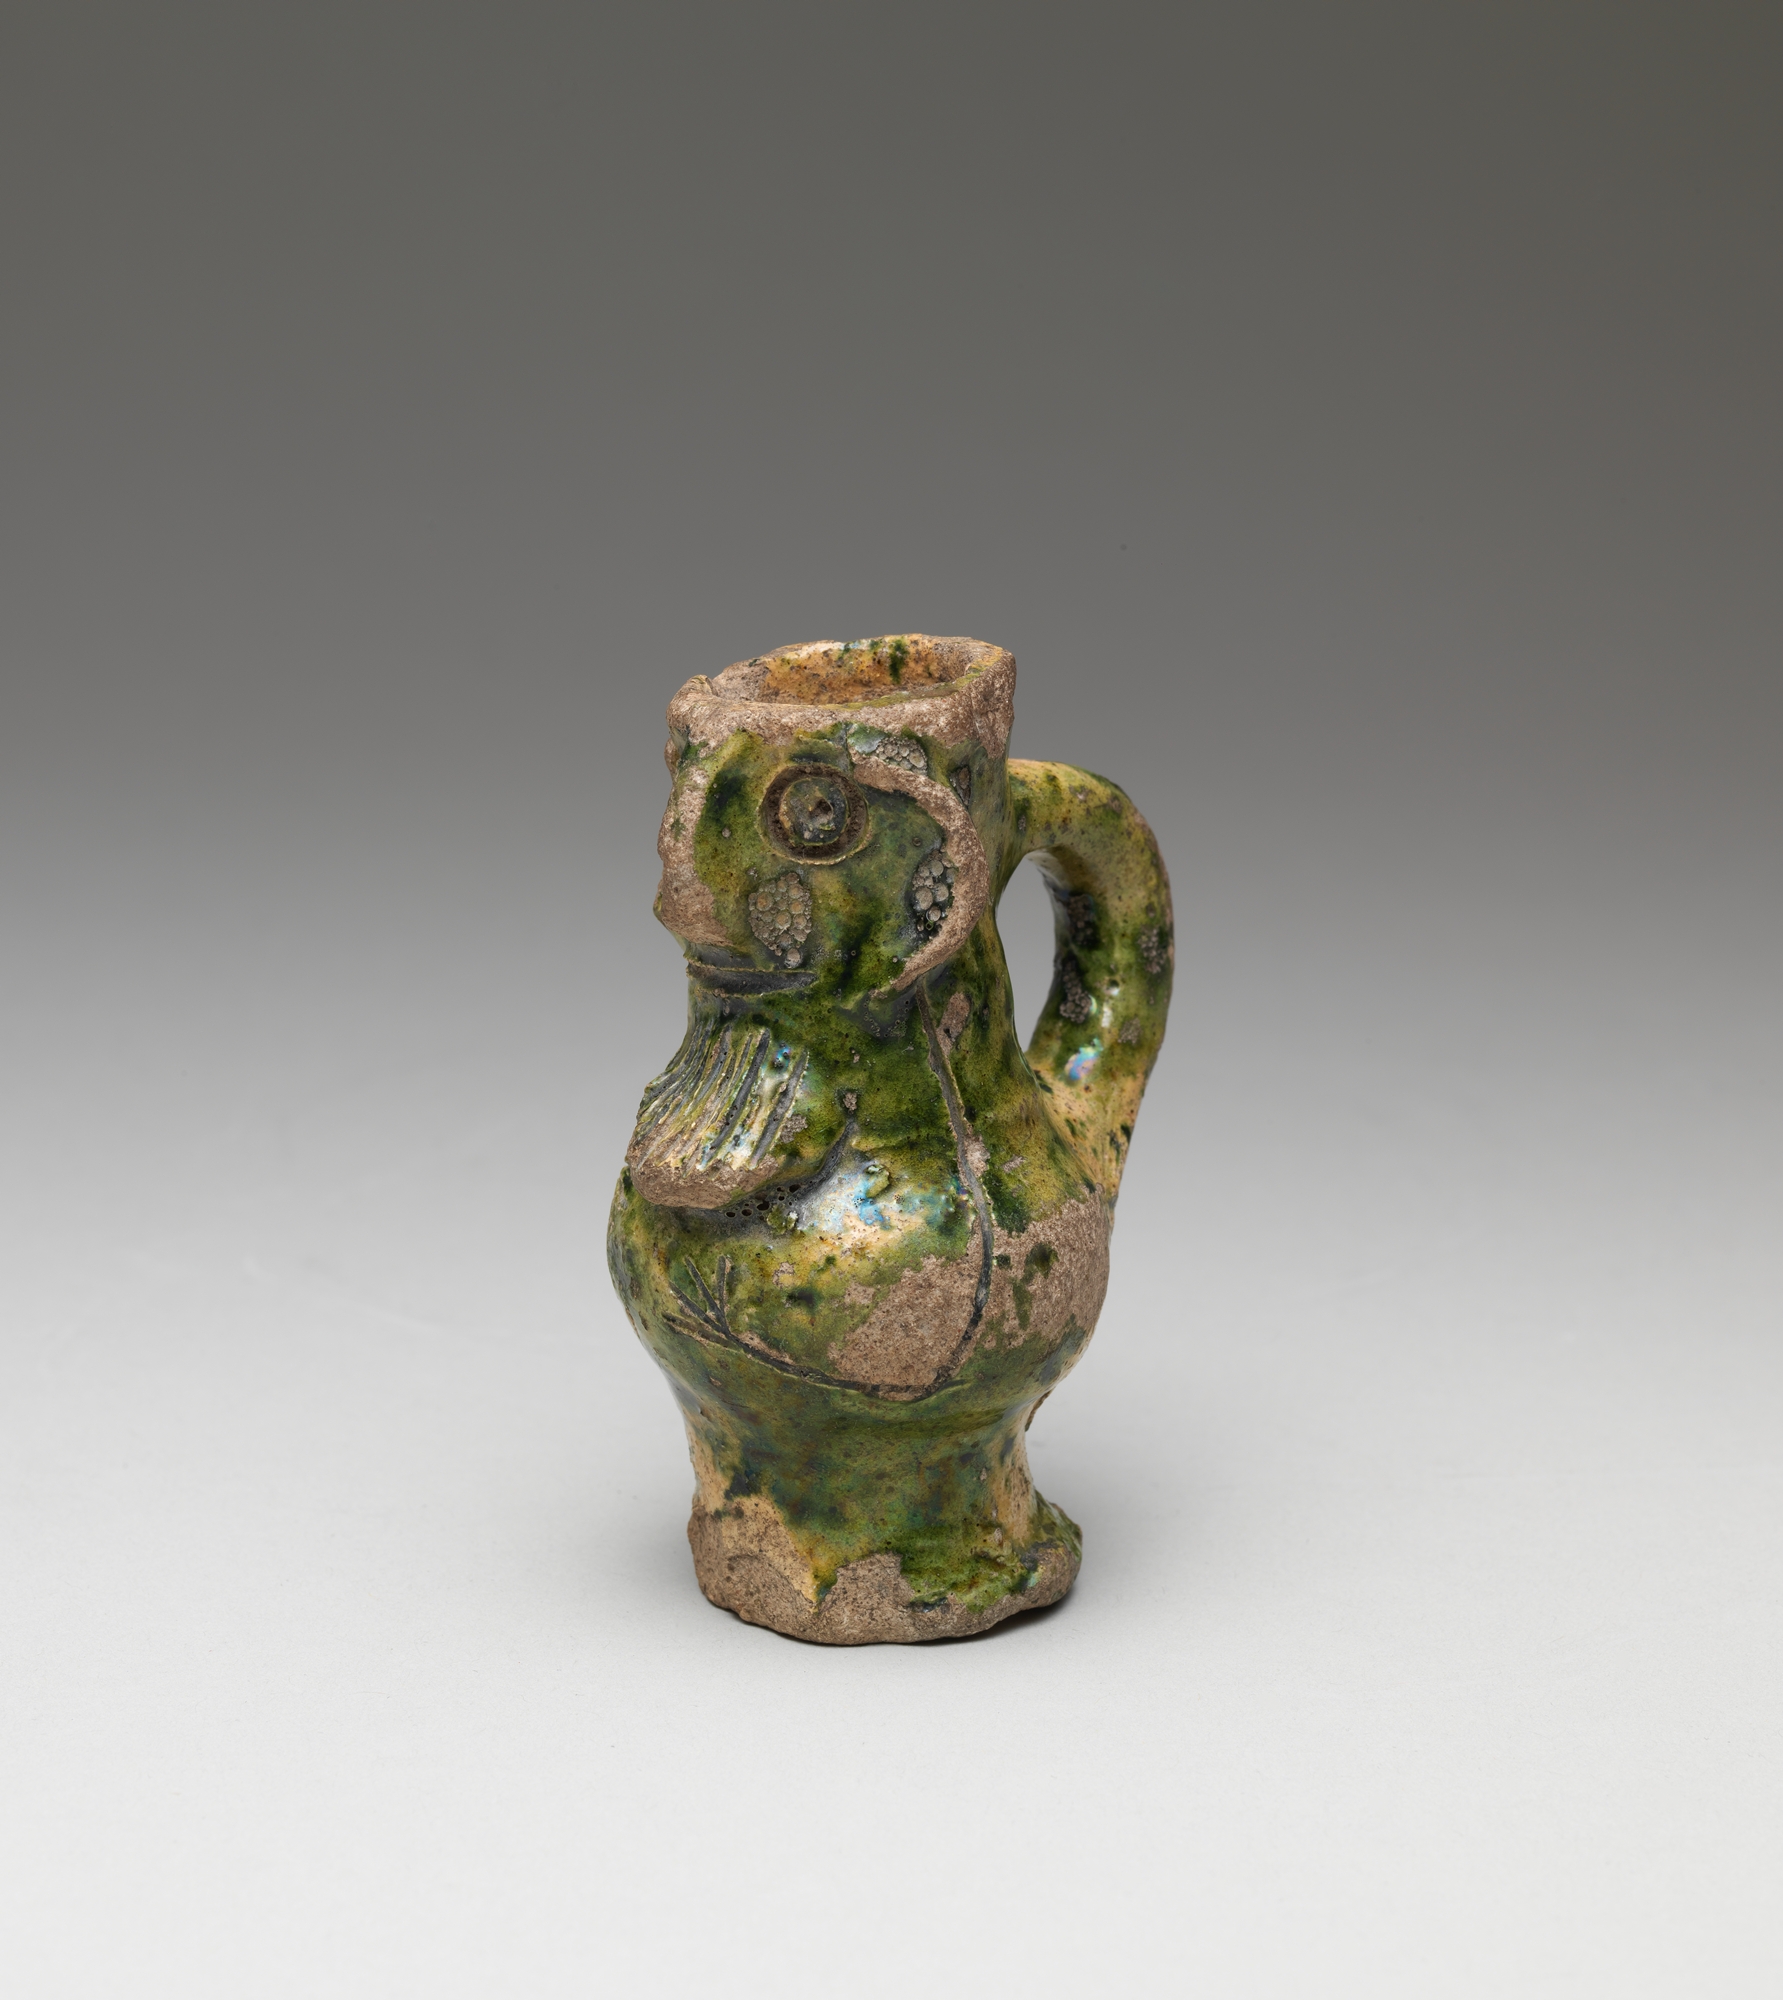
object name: jug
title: Face Jug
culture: british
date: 1301-1400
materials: earthenware, glaze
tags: faces